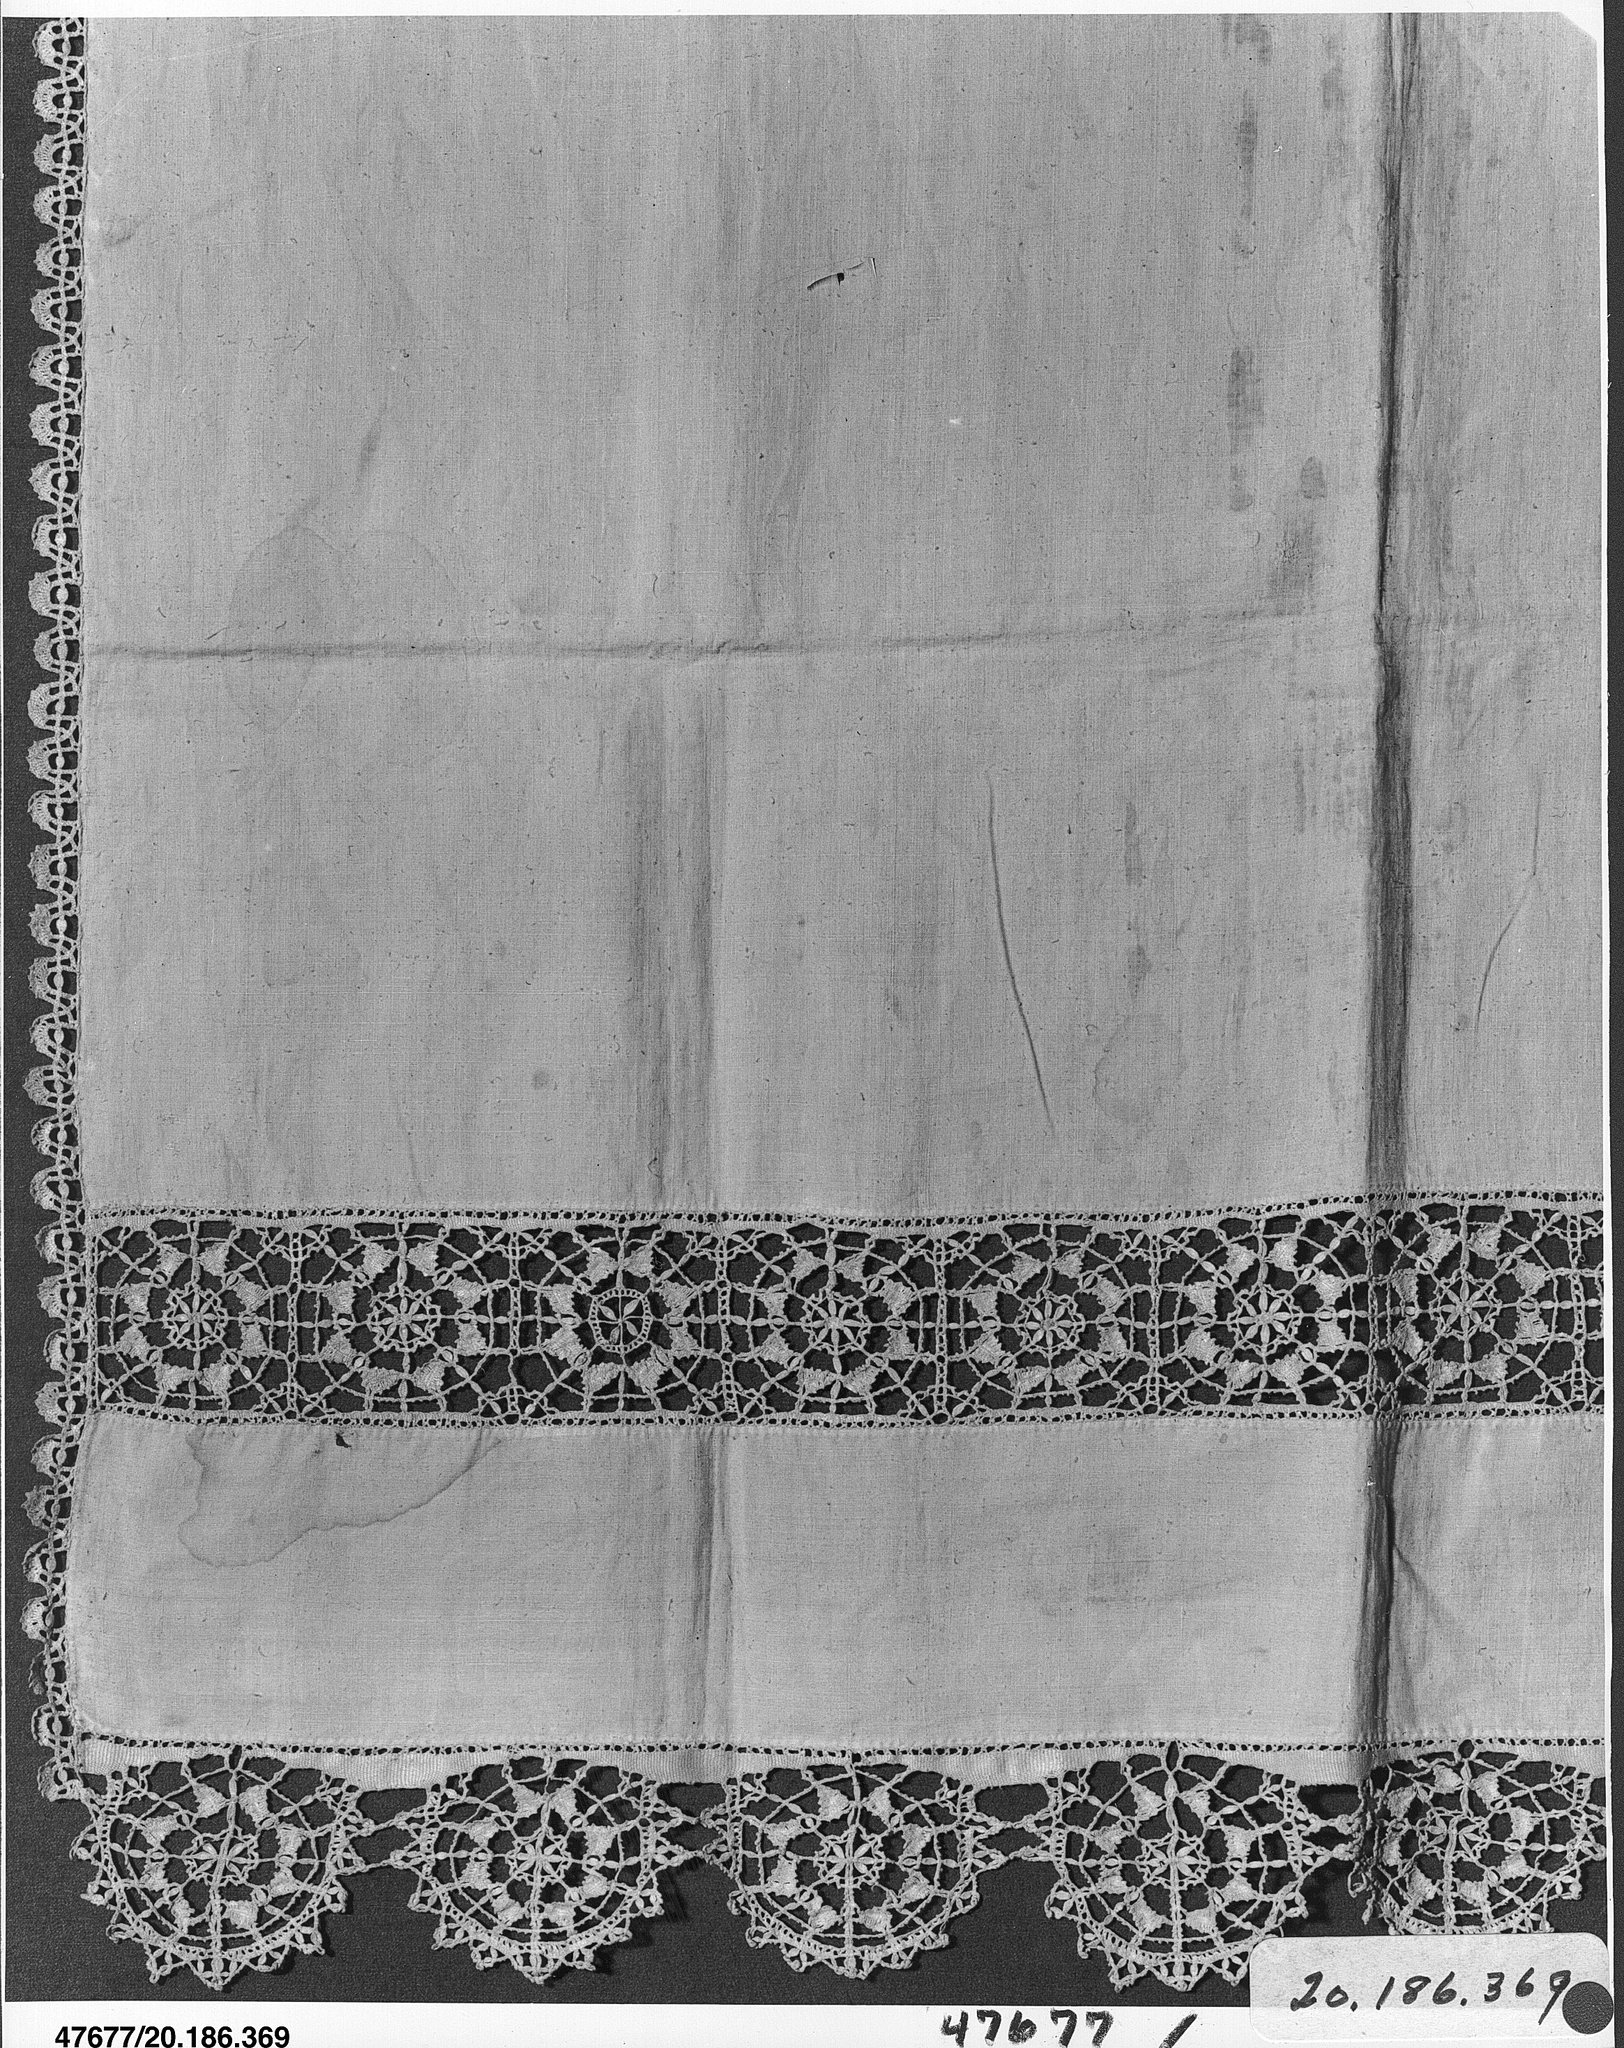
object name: altar cloth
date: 1551-1600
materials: linen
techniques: lace